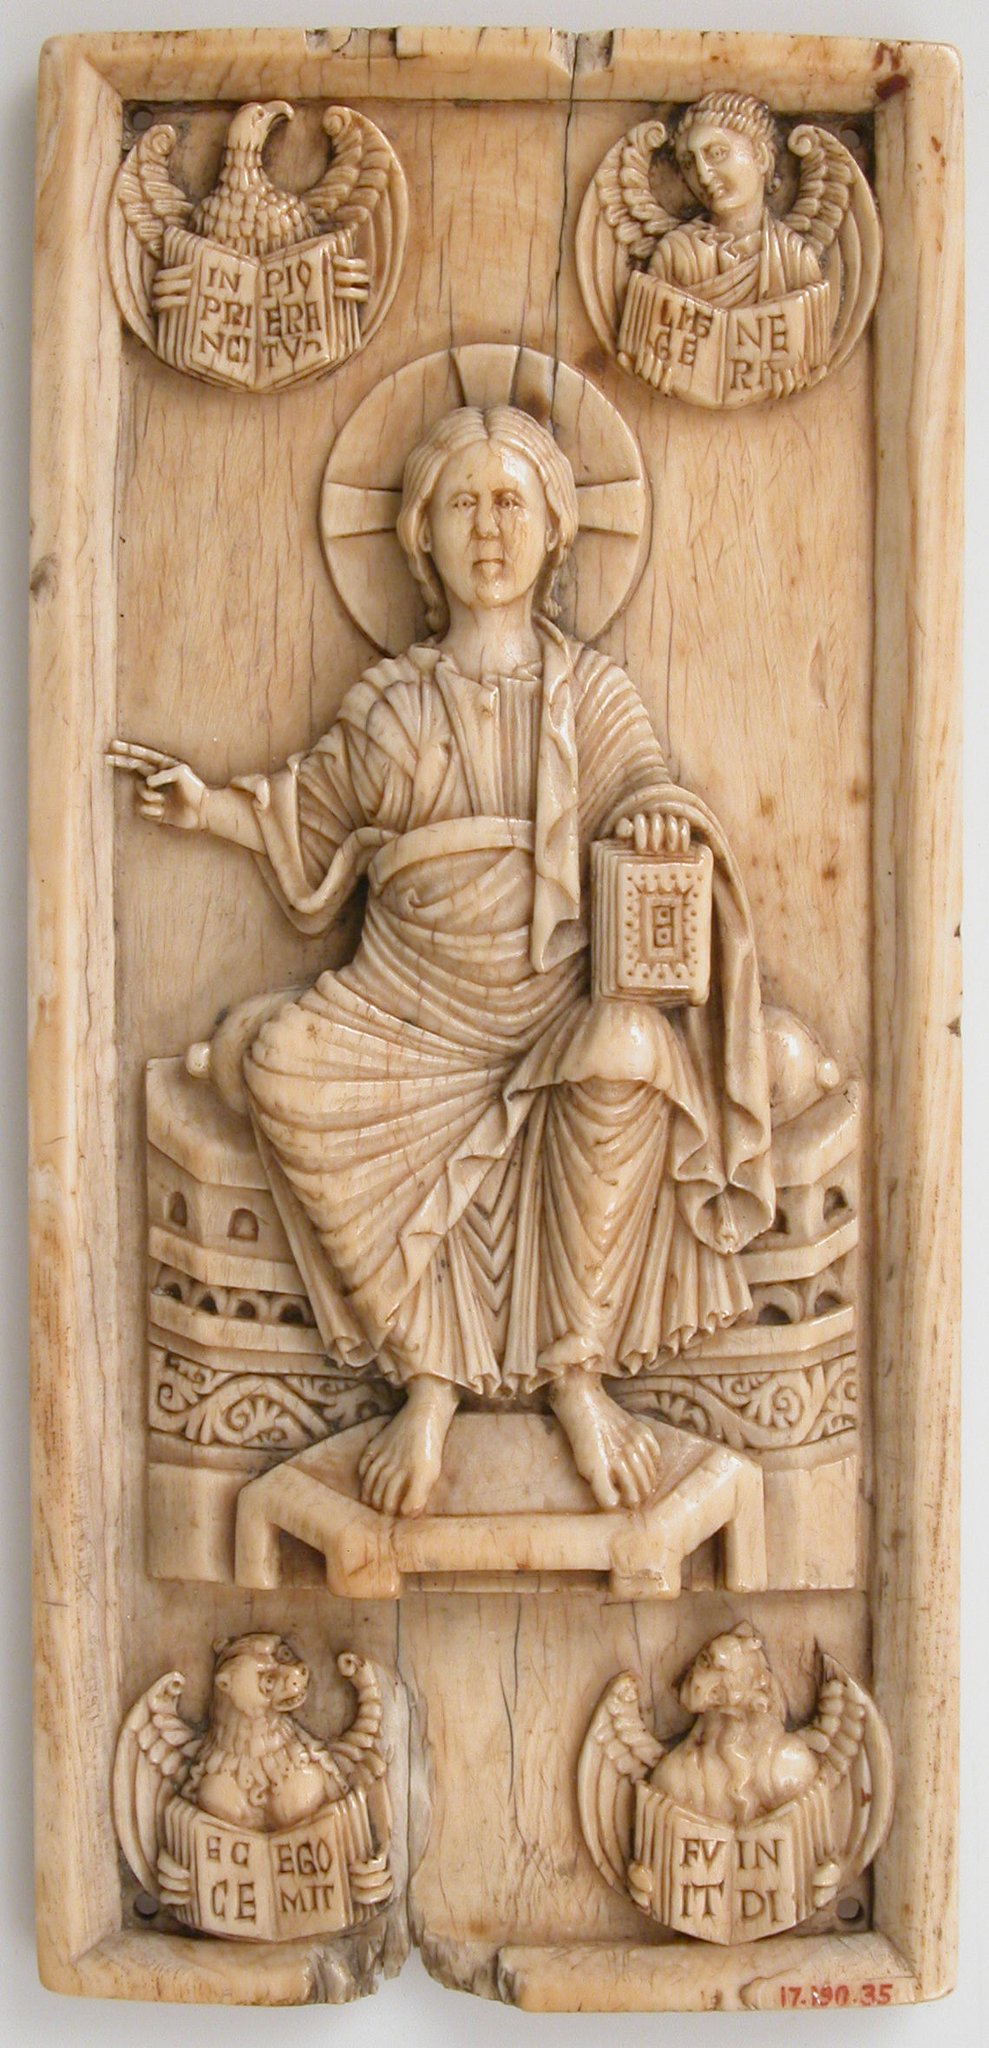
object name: book cover plaque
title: Book Cover Plaque with Christ in Majesty and the Symbols of the Four Evangelists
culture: german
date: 1001-1100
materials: ivory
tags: angels,christ